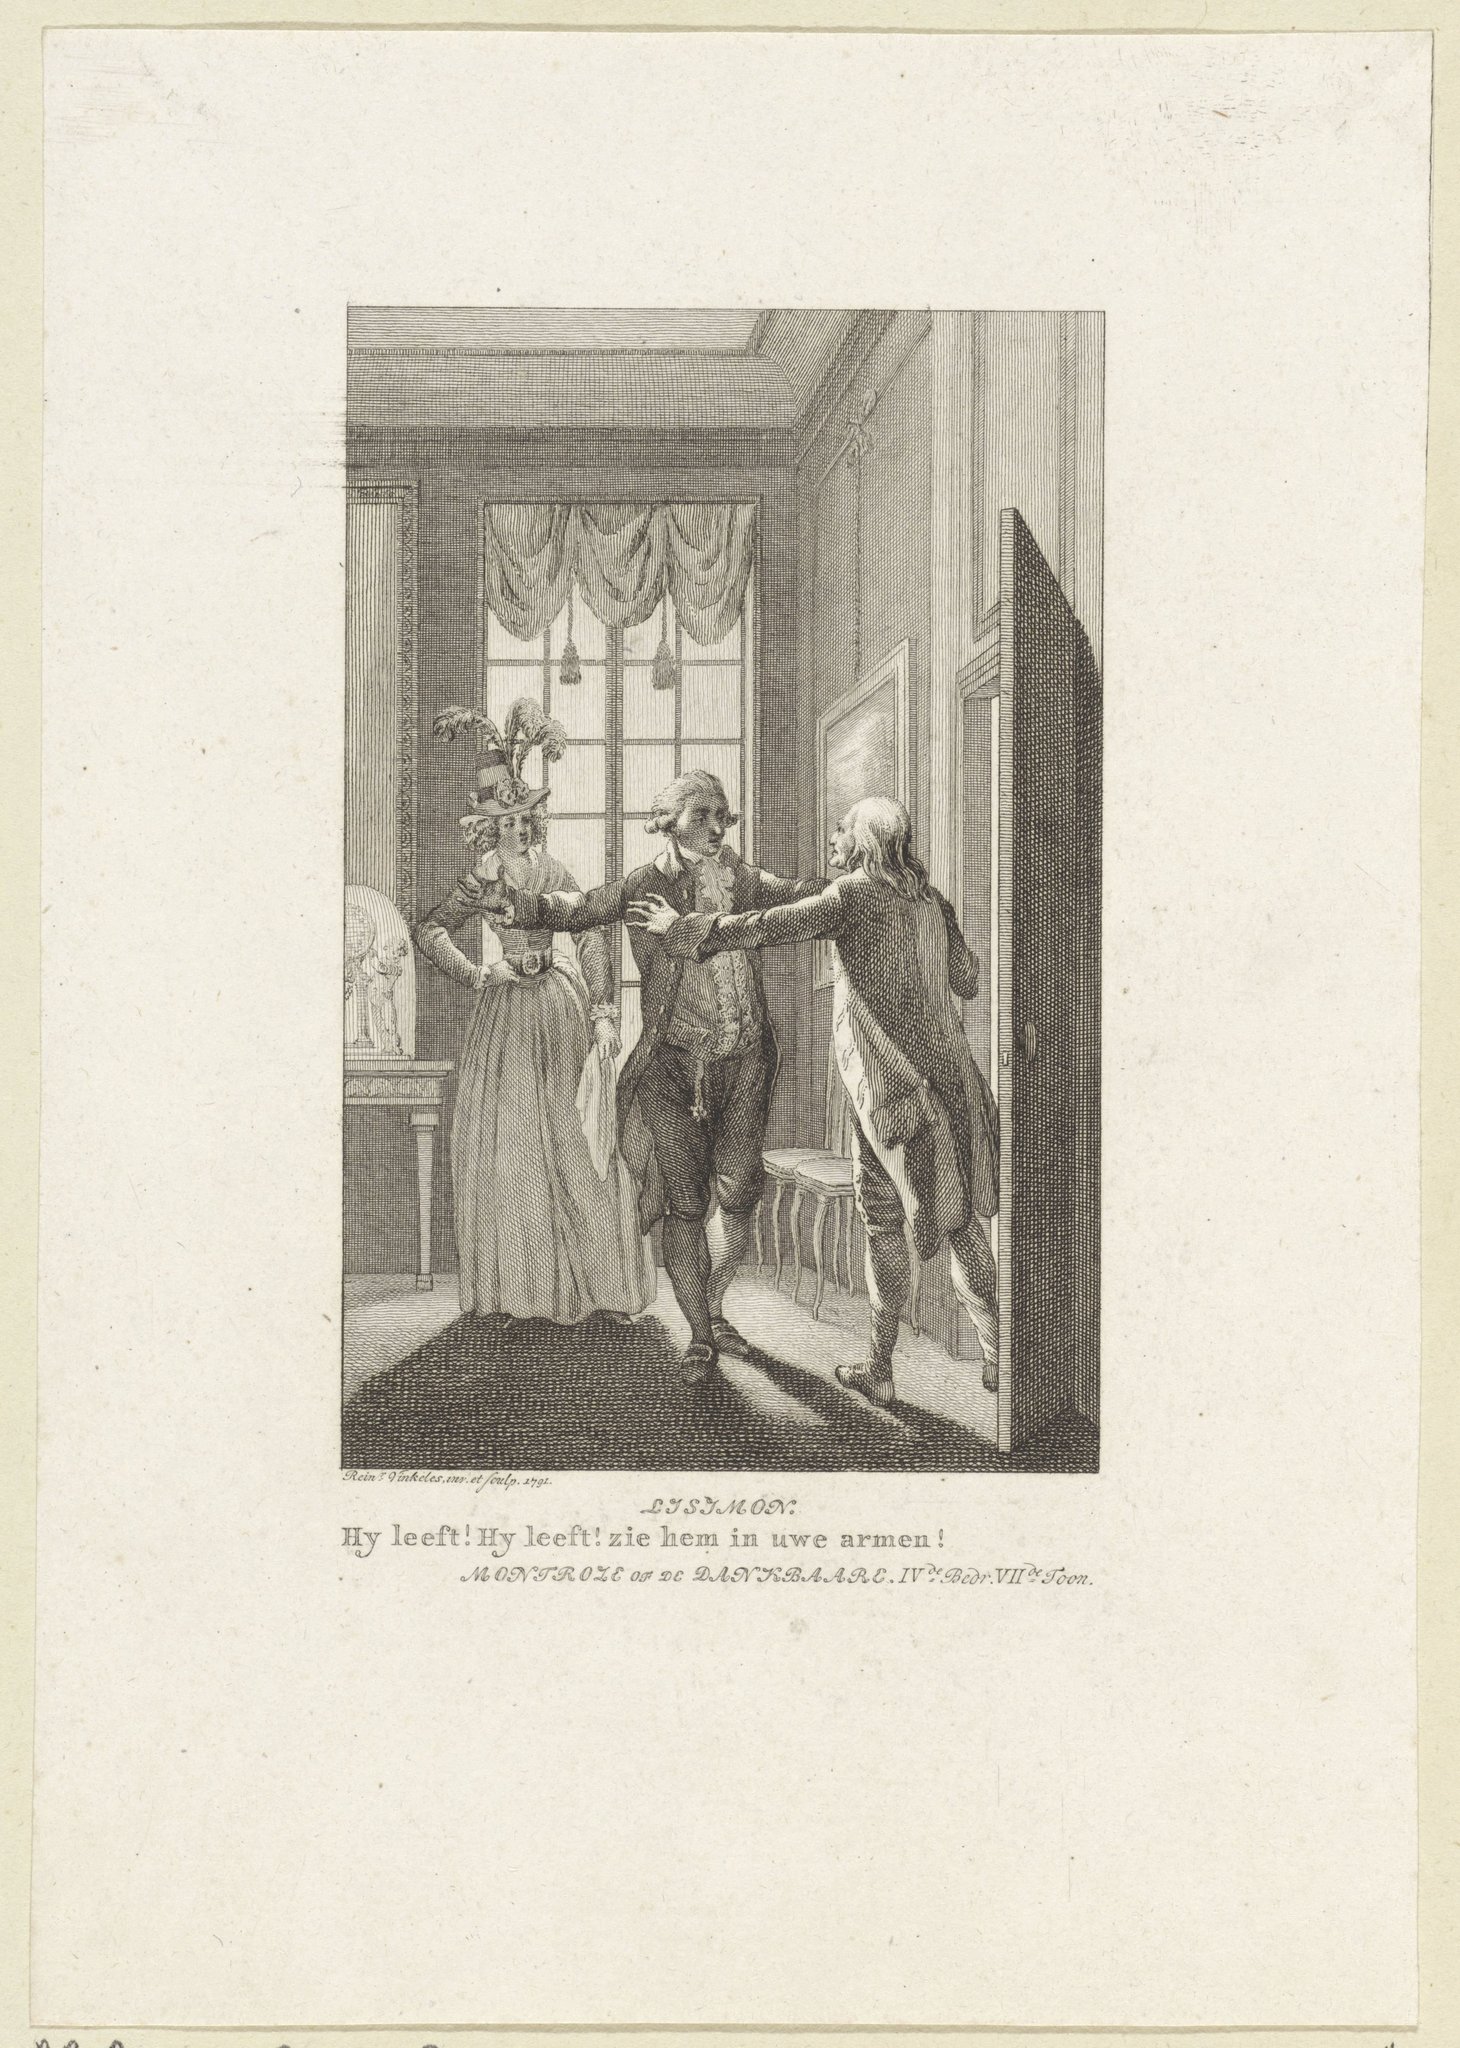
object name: print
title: Wederzien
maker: reinier vinkeles (i)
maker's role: draughtsman, print maker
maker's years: 1741-1816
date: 1791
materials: paper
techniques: engraving, etching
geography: amsterdam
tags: embracing each other, kissing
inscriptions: collector's mark: Lugt 240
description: Deze prent is mogelijk ook gebruikt als illustratie in: Dejaure, Jean-Claude Bédéno. Montroze of De dankbaare. Amsterdam: erven van Pieter Meĳer en Gerrit Warnars, 1791.